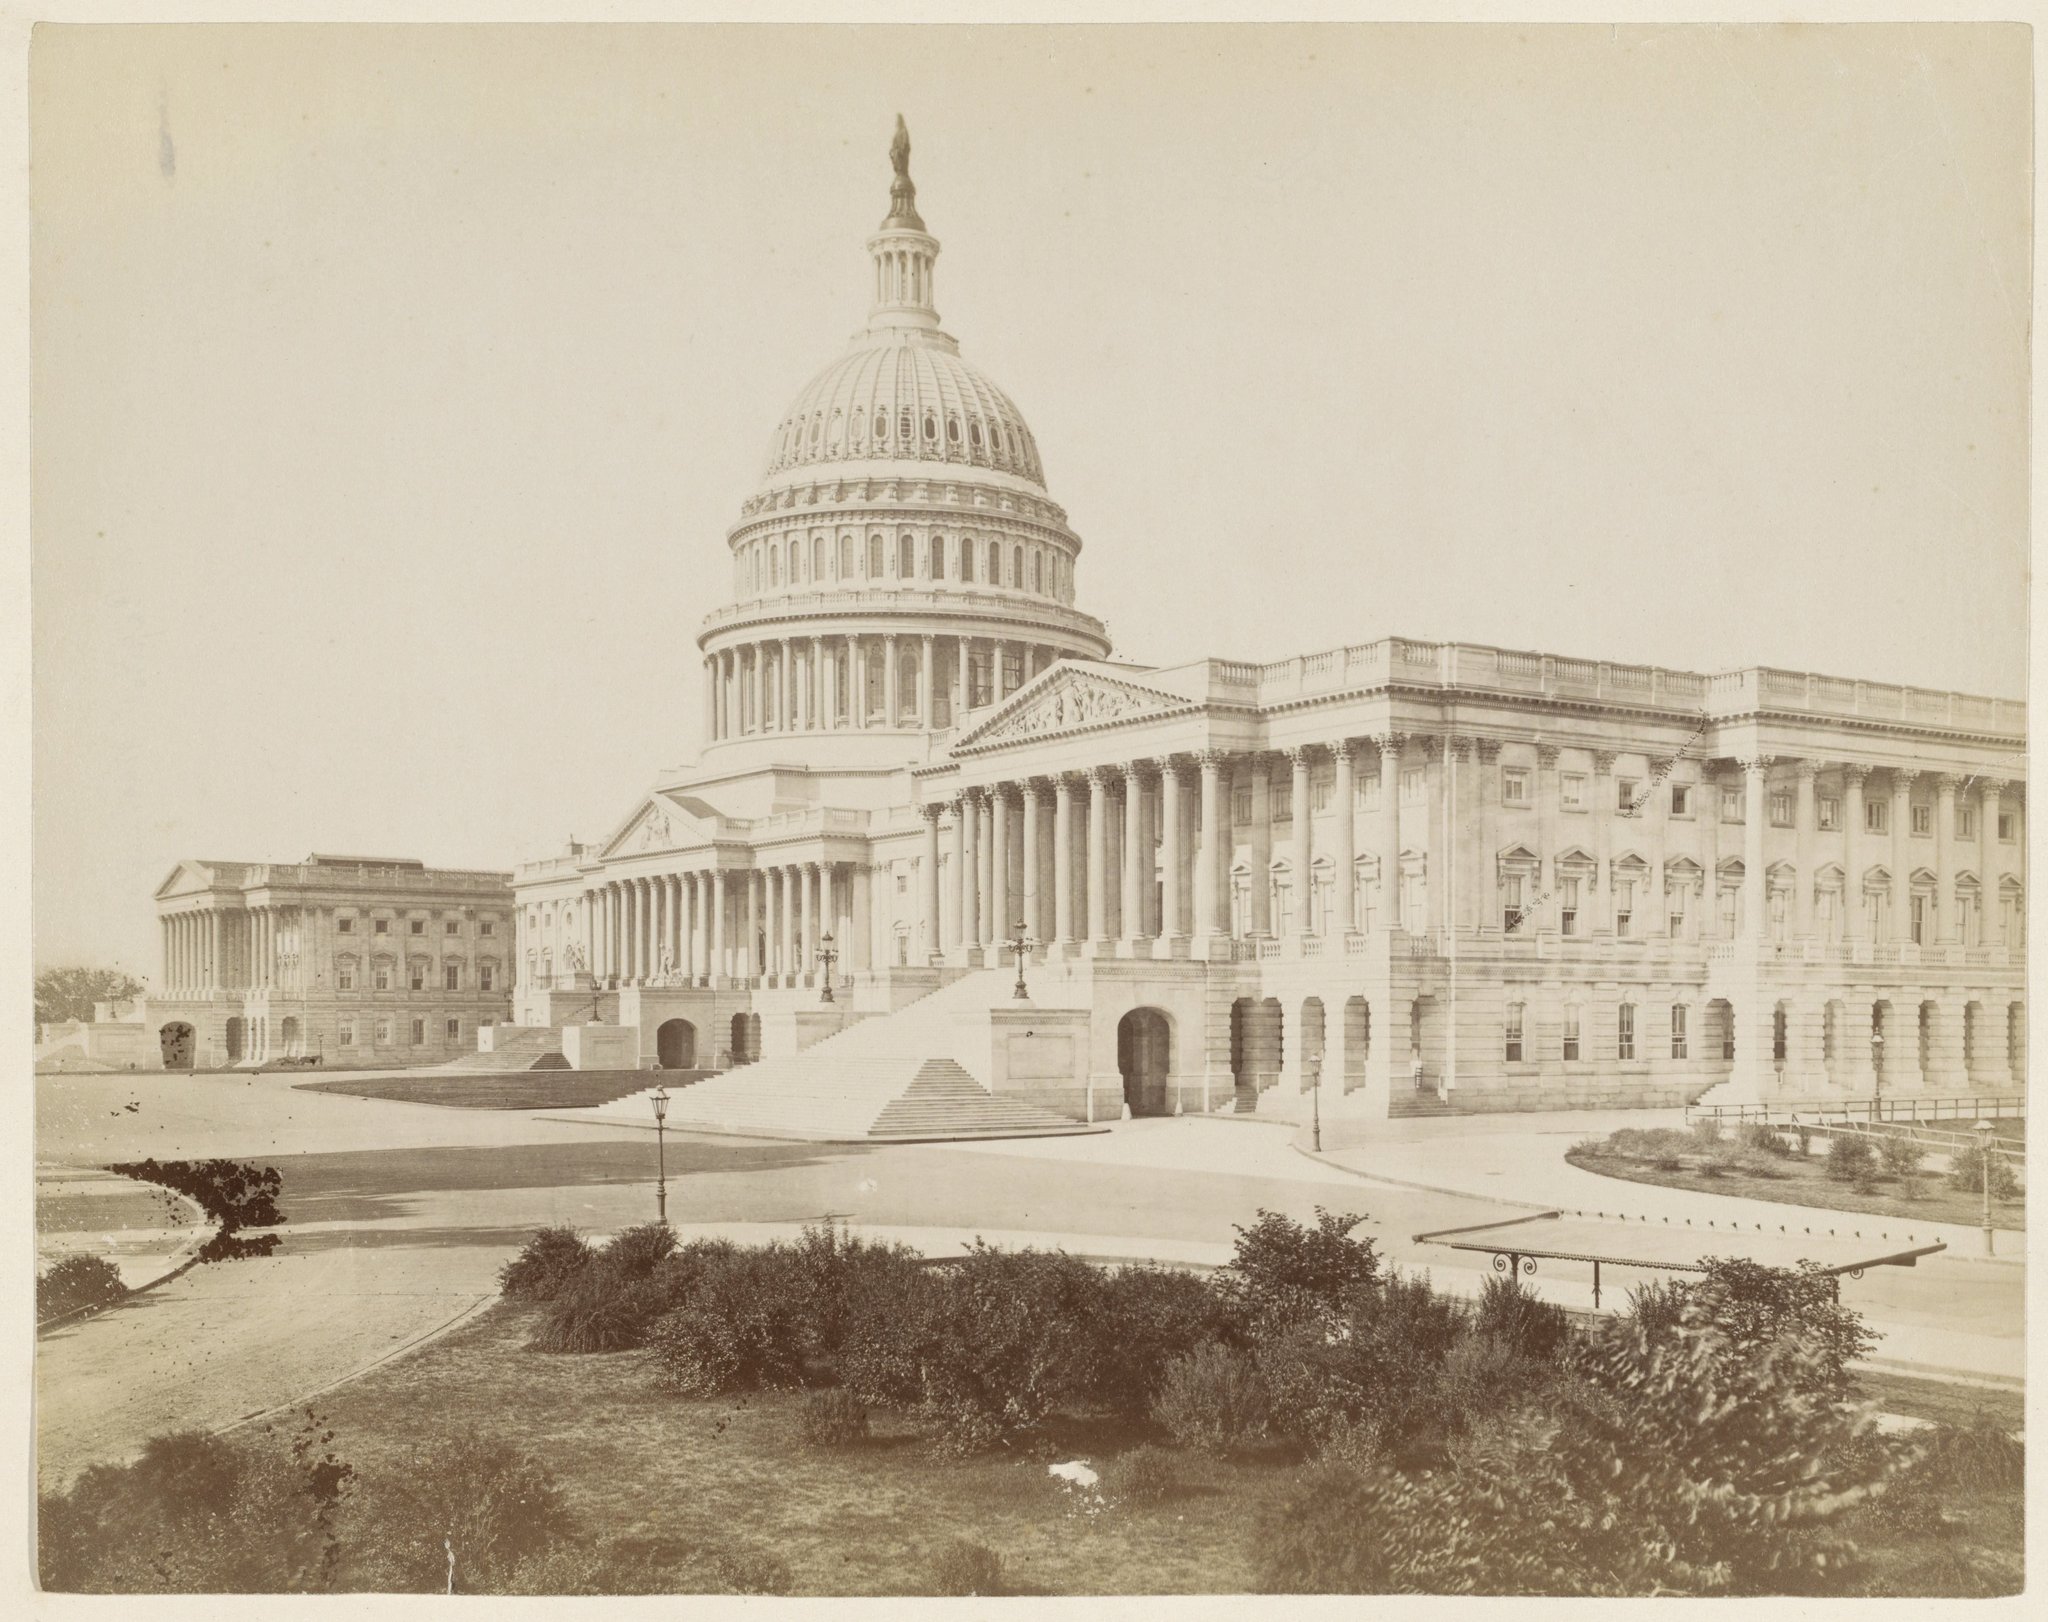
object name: photograph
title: Gezicht op de oostzijde en de koepel van het Capitool in Washington D.C.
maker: Anonymous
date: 1880-1900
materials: cardboard, paper, photographic support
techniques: albumen print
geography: washington d.c.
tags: dome ~ architecture